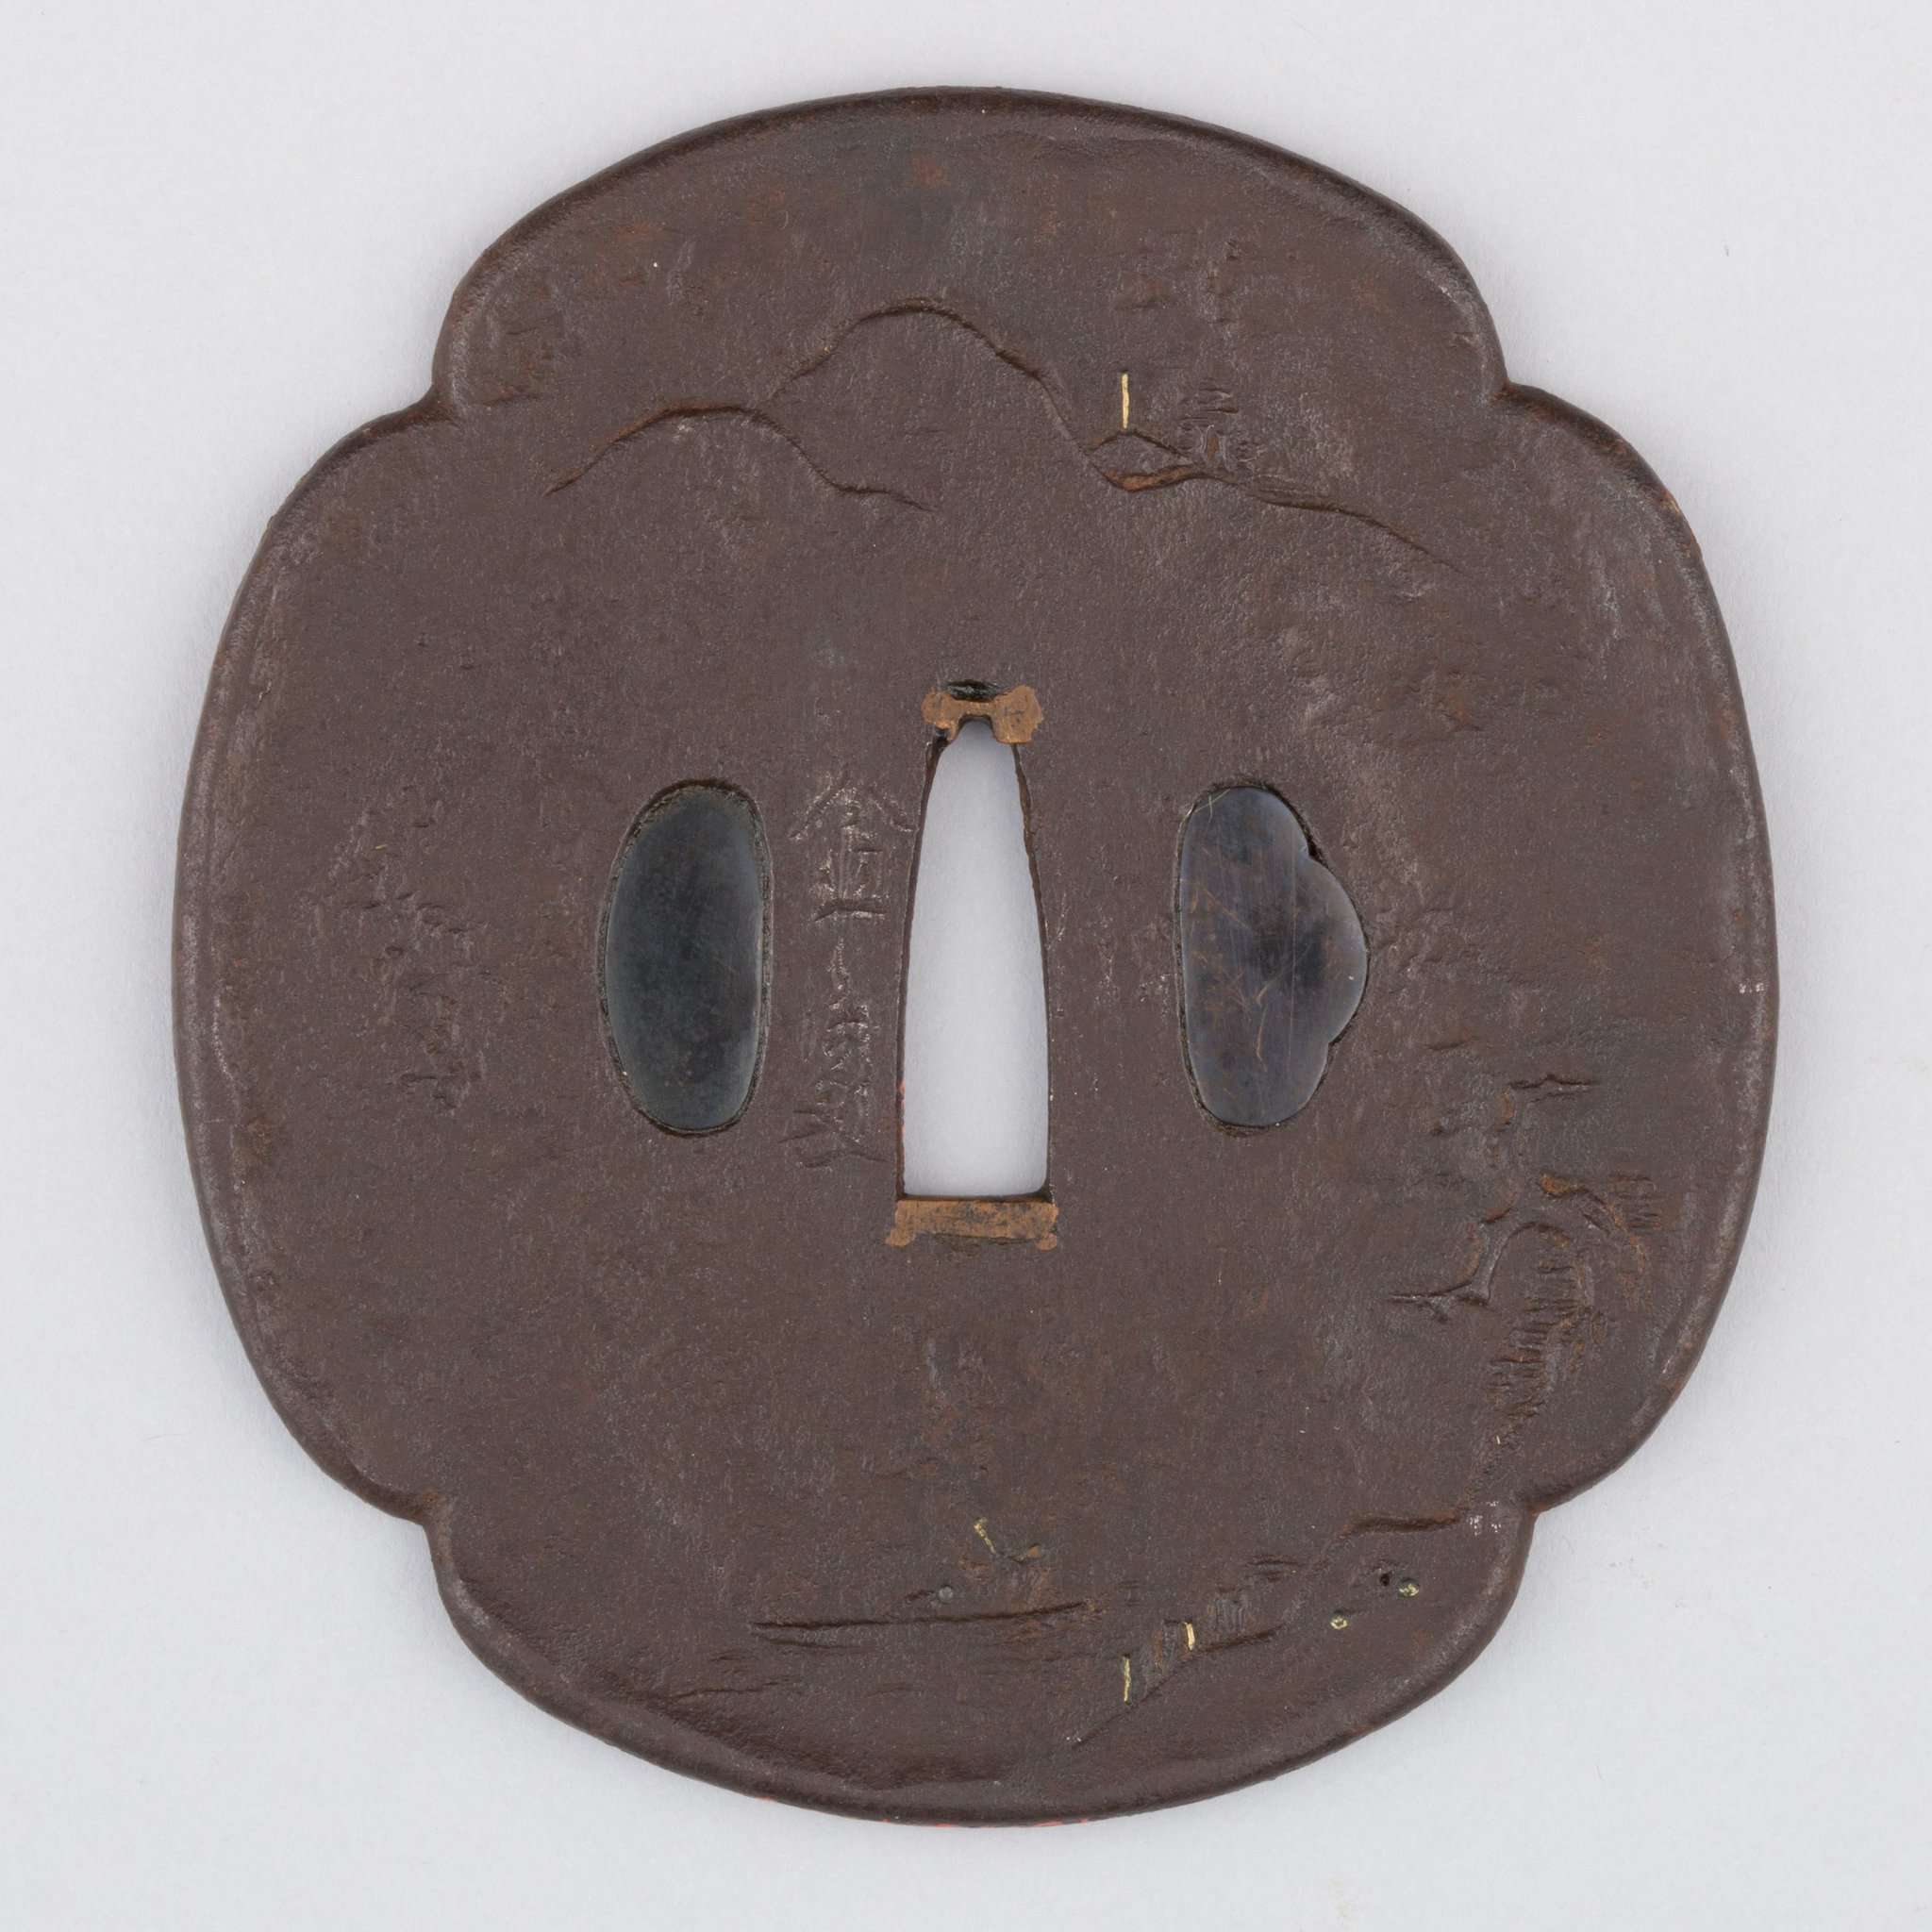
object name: sword guard tsuba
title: Sword Guard (Tsuba)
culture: japanese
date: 1615-1868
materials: copper, iron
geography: japan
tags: boats